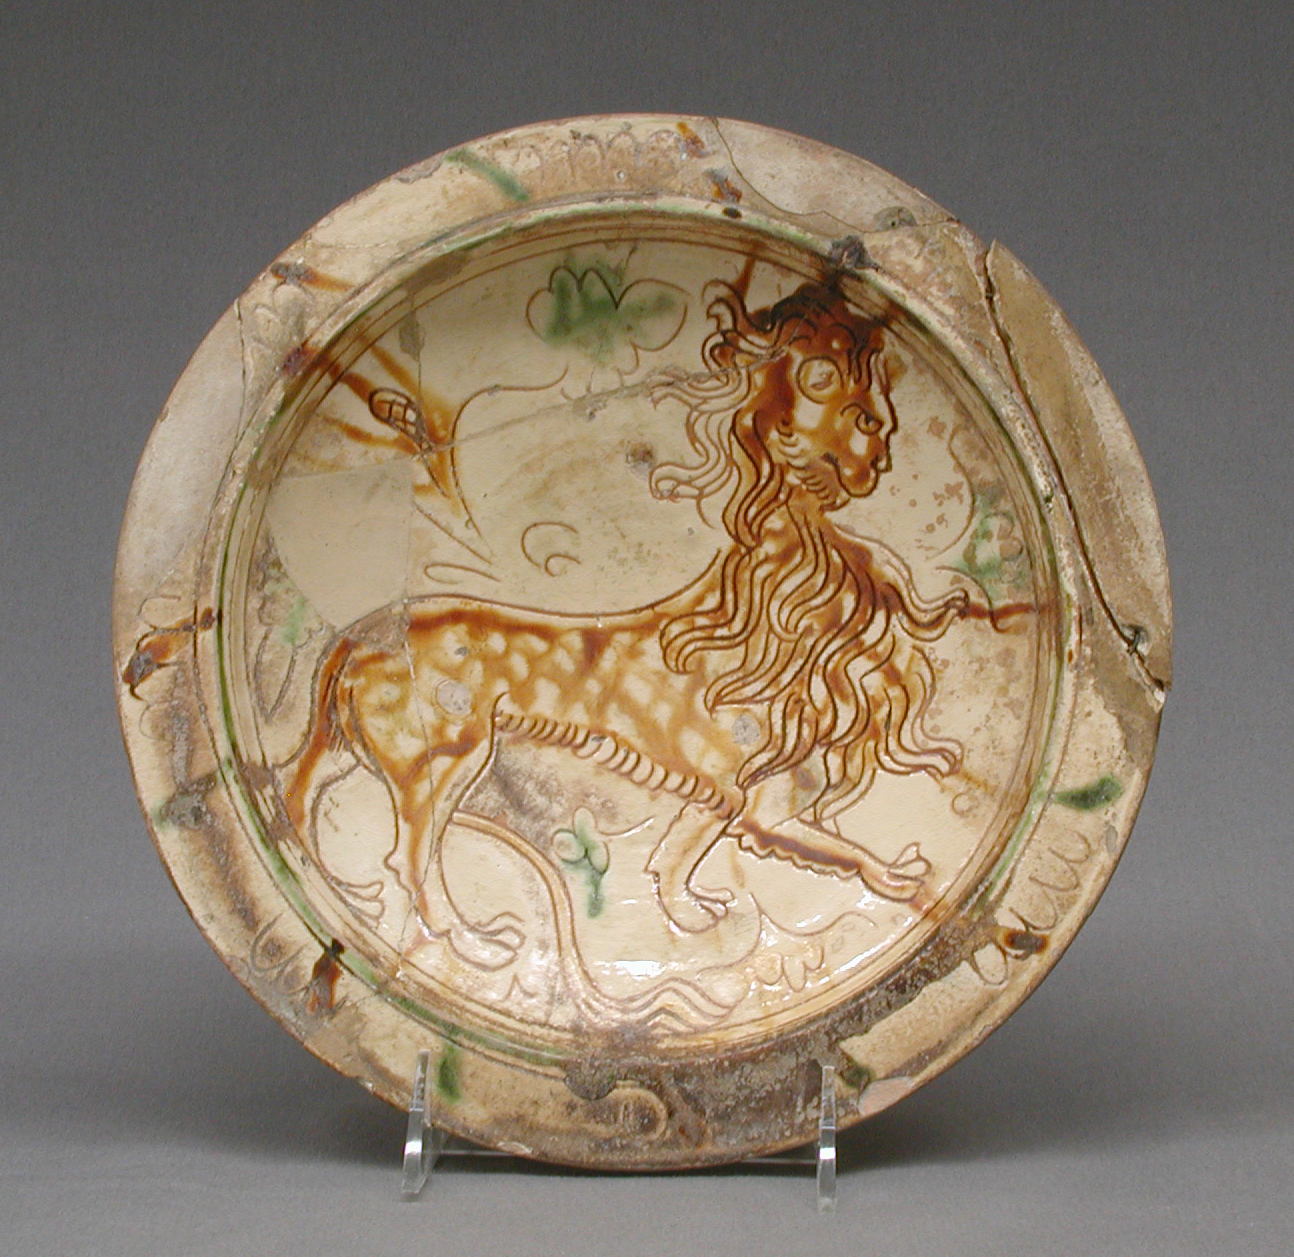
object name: dish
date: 1601-1700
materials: earthenware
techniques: glazing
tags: lions